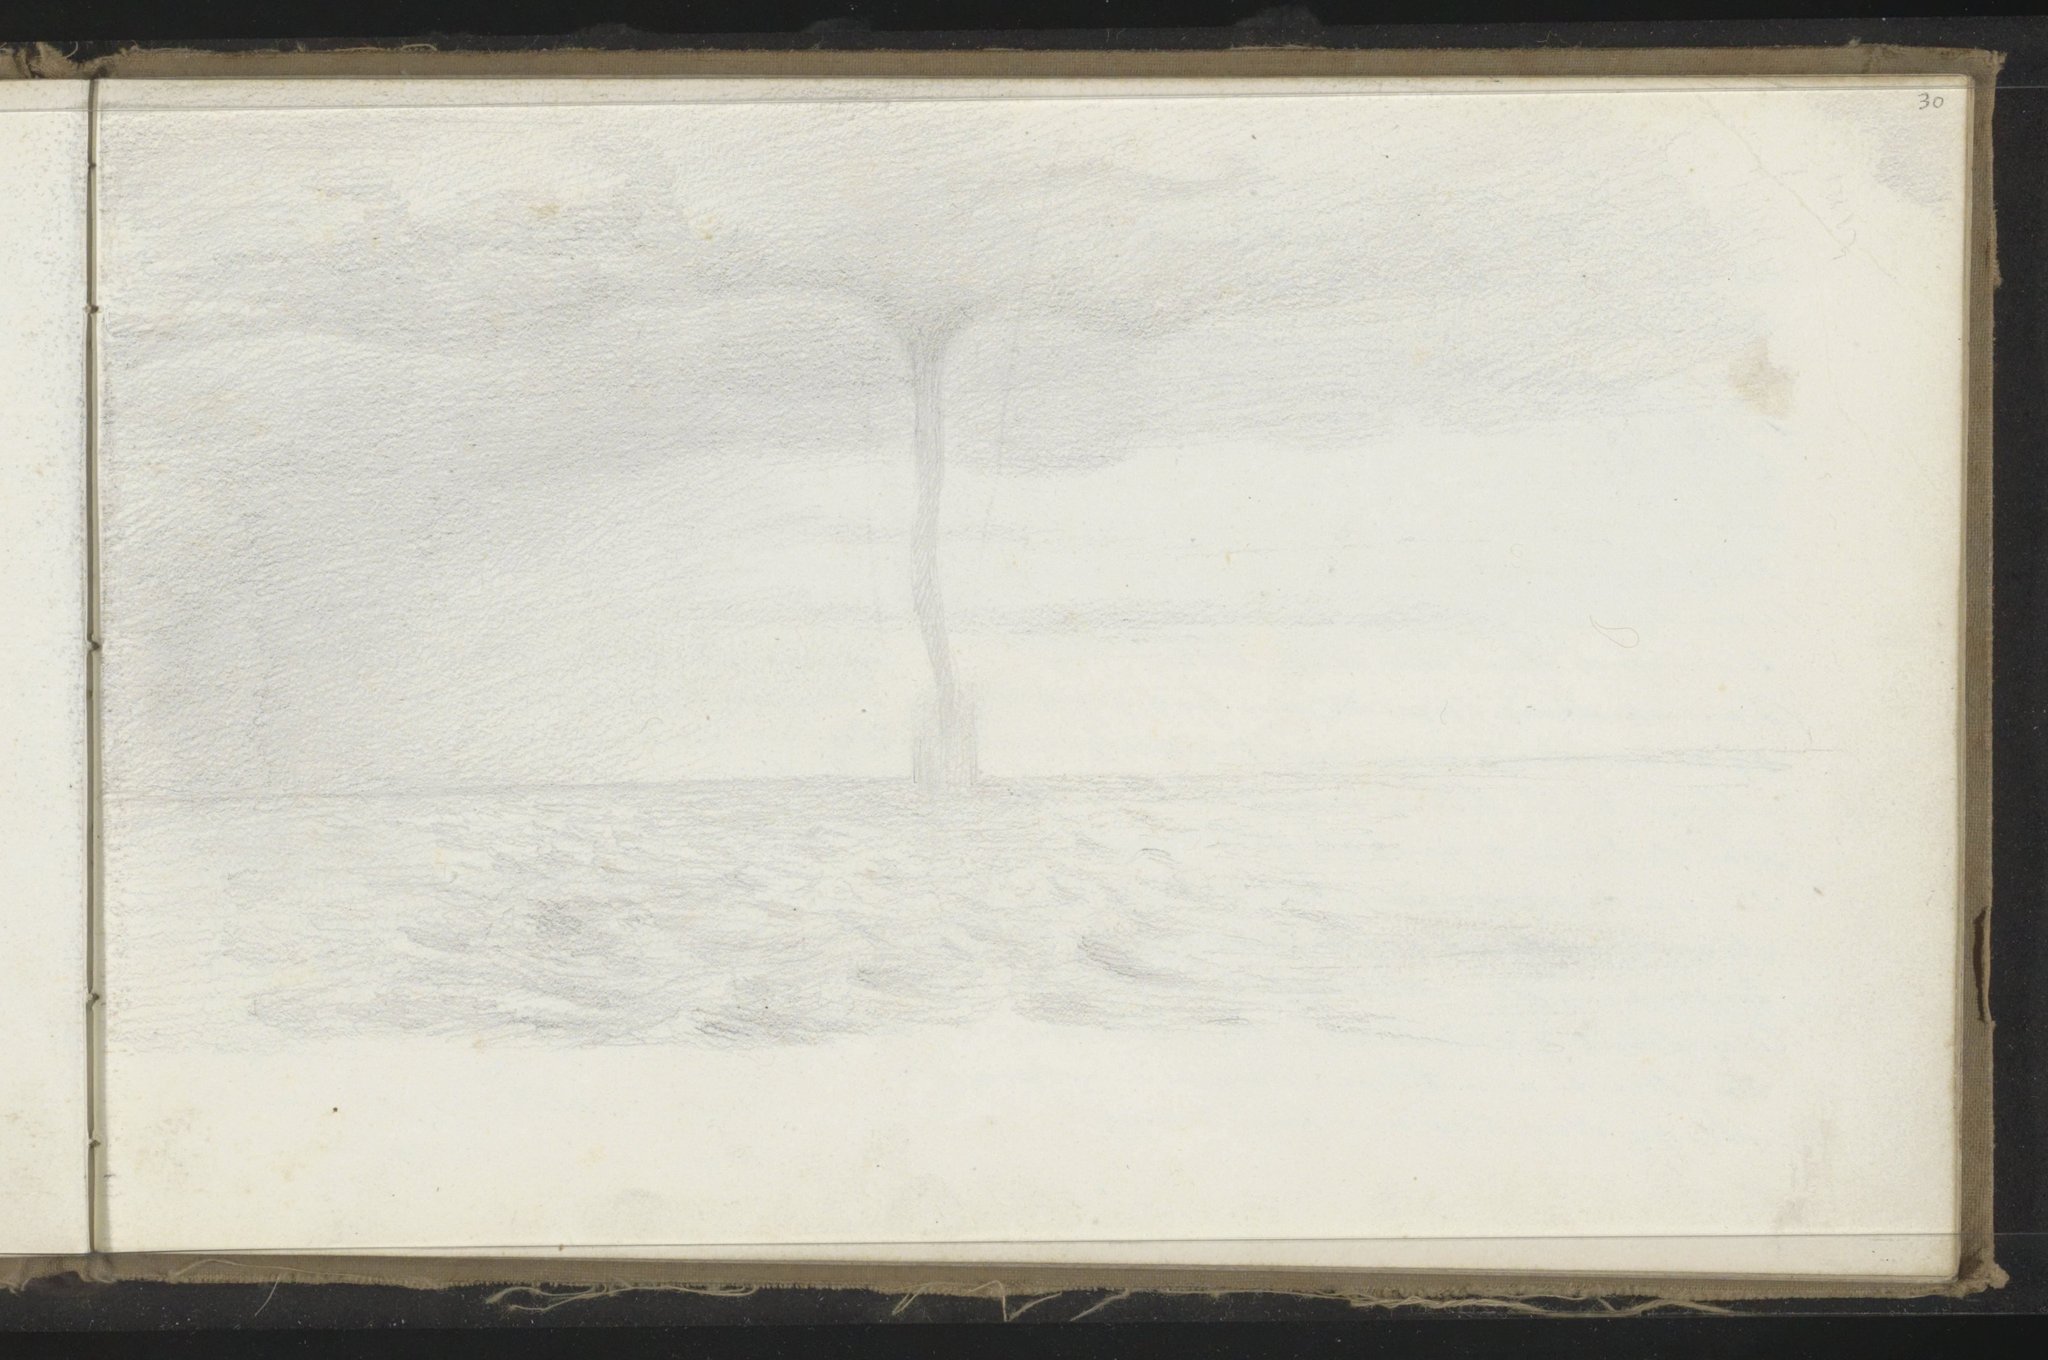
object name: sketchbook leaf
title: Wervelstorm op zee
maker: christian heinrich gottlieb steuerwald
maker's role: draughtsman, print maker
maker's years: 1802-1874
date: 1848-1854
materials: paper, pencil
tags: whirlwind, cyclone, hurricane, typhoon, tornado at sea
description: Blad 30 recto uit een schetsboek met 58 bladen.